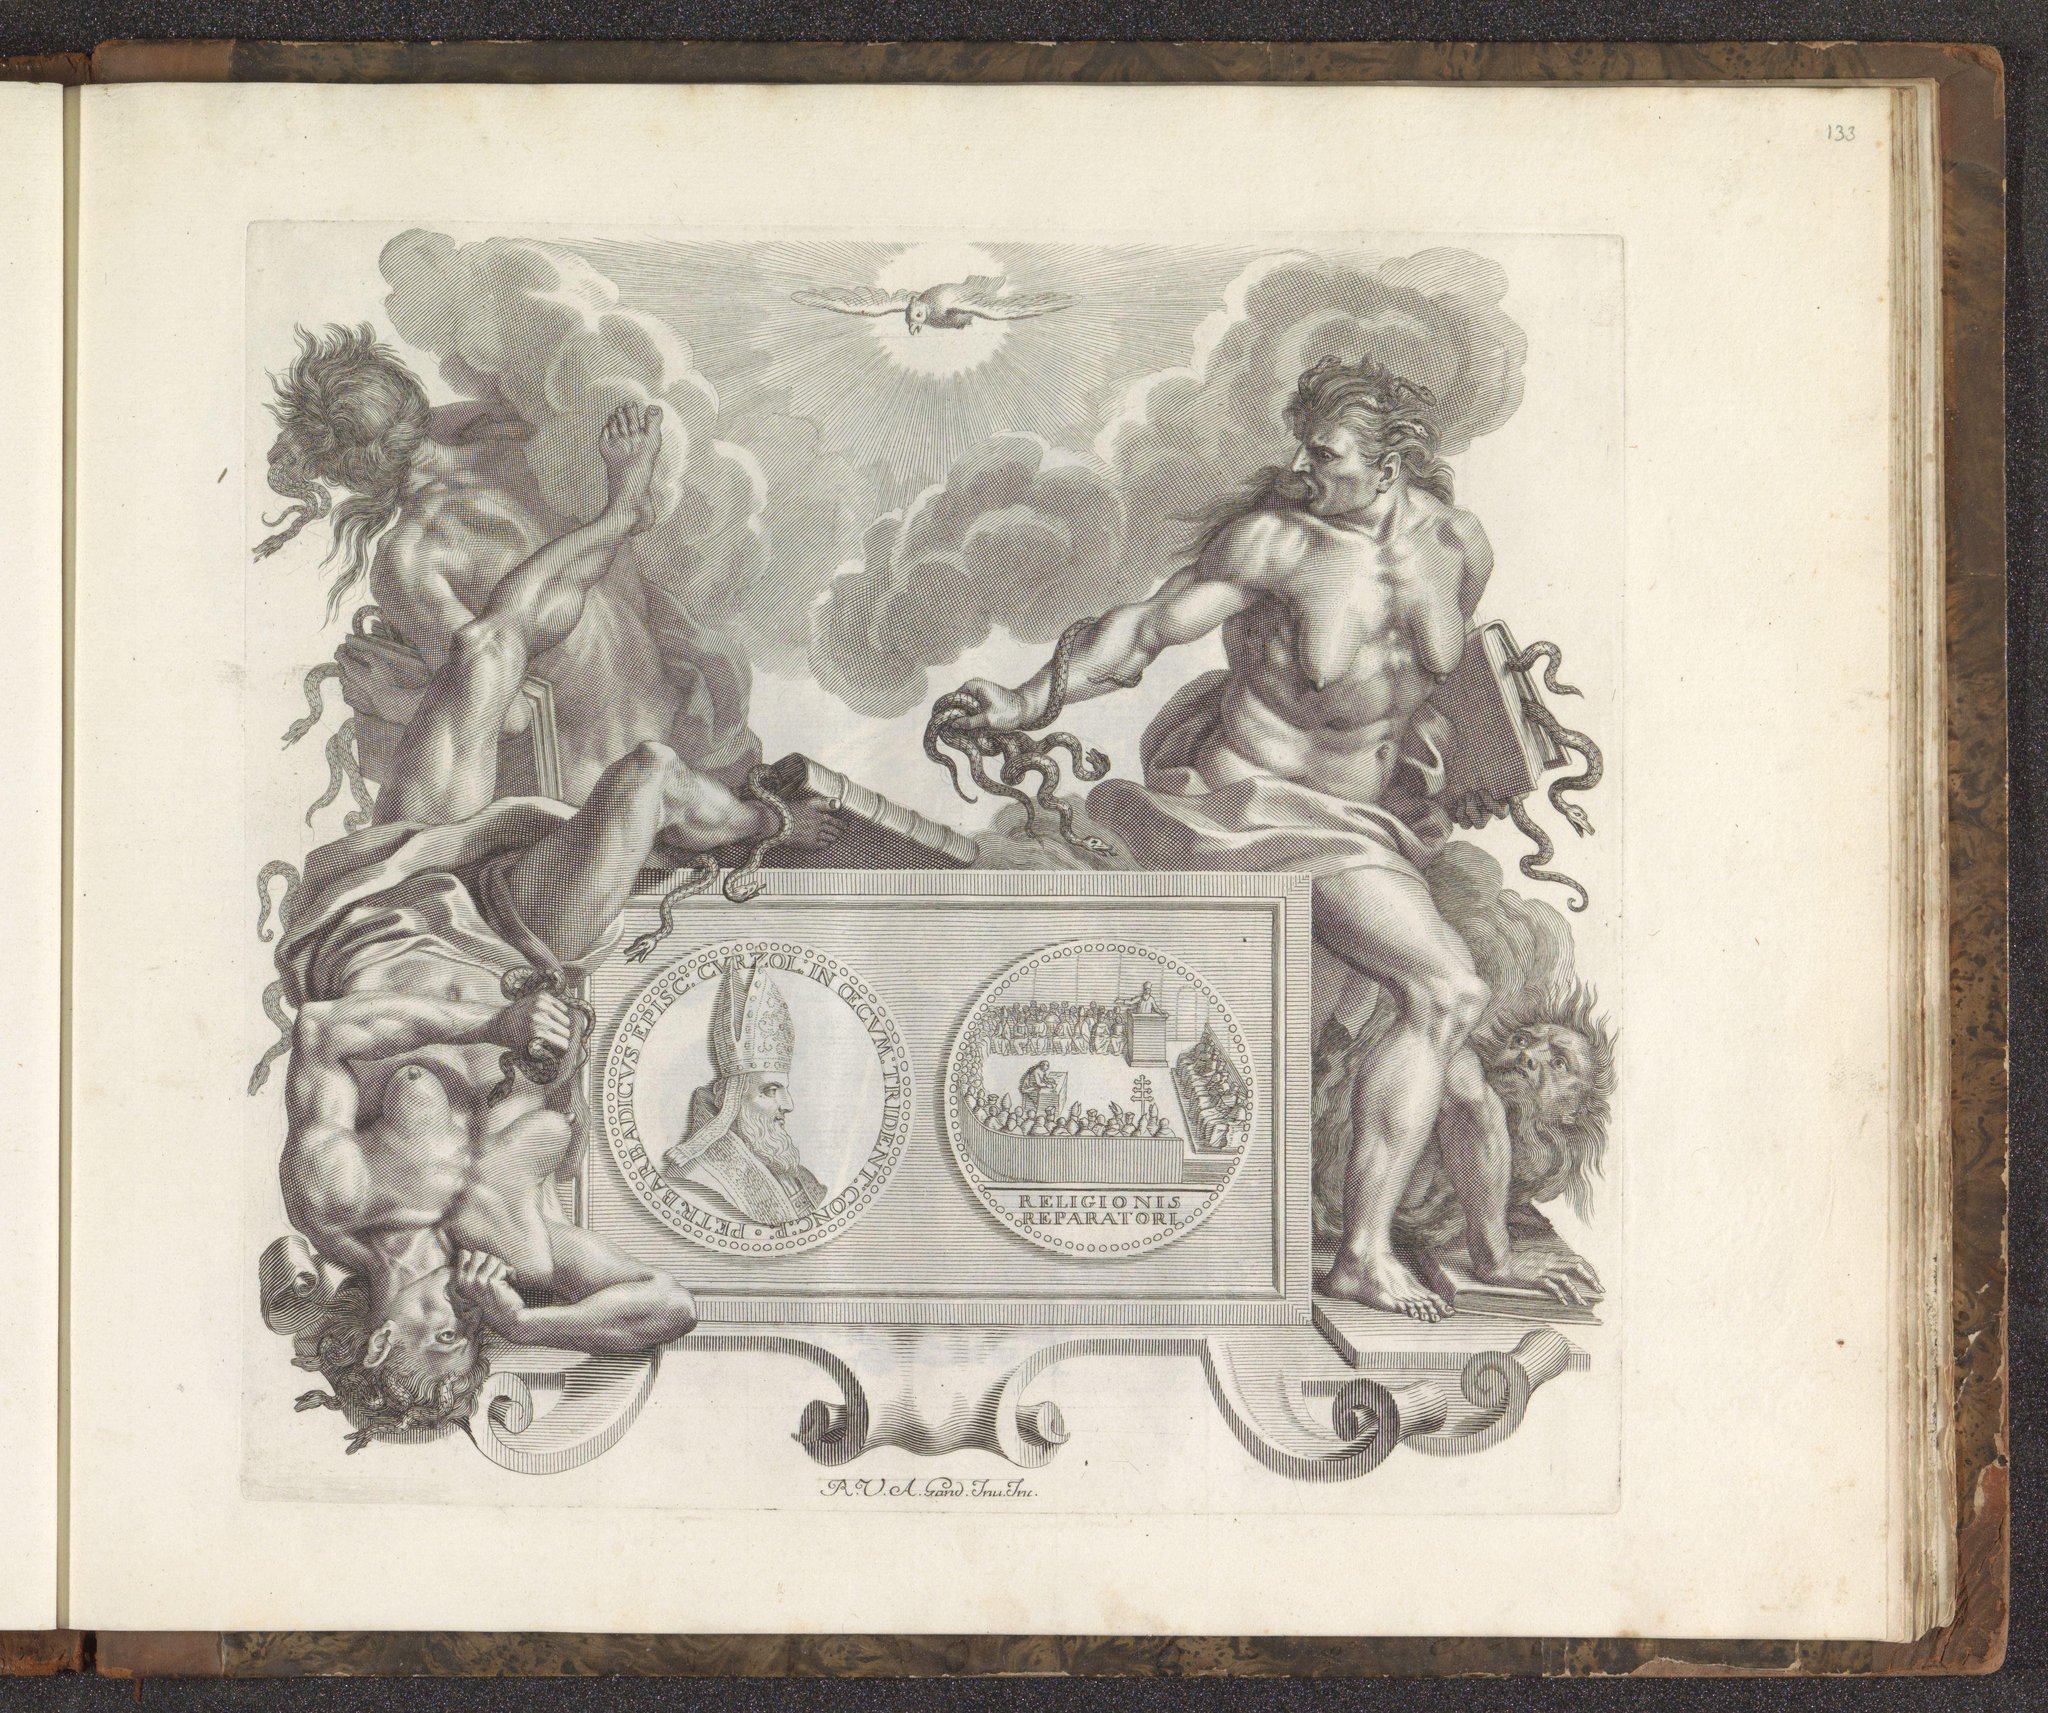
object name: print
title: Portret van Pietro Barbarigo en de personificaties van Afgunst en Ketterij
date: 1673-1743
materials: paper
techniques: engraving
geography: rome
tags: snakes, envy; 'invidia' (ripa) ~ personification of one of the seven deadly sins, medal (considered as a piece of sculpture, regardless of its specific function), book, heresy; 'heresia' (ripa)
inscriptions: collector's mark: Lugt 2228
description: Voetstuk in de vorm van een cartouche. Daarop een medaillon met op de voorzijde het portret van Pietro Barbarigo met bisschopsmijter. Op de achterkant het kerkelijk Concilie van Trente. Het voetstuk wordt geflankeerd door de personificaties van Afgunst en Ketterij. Het betreft vrouwen met een mager lichaam. De vrouw linksvoor houdt een hand voor haar mond. Rechts komt er rook uit de mond van een vrouw. Daarbij enkele boeken waaruit slangen kruipen. De prent maakt deel uit van een album.